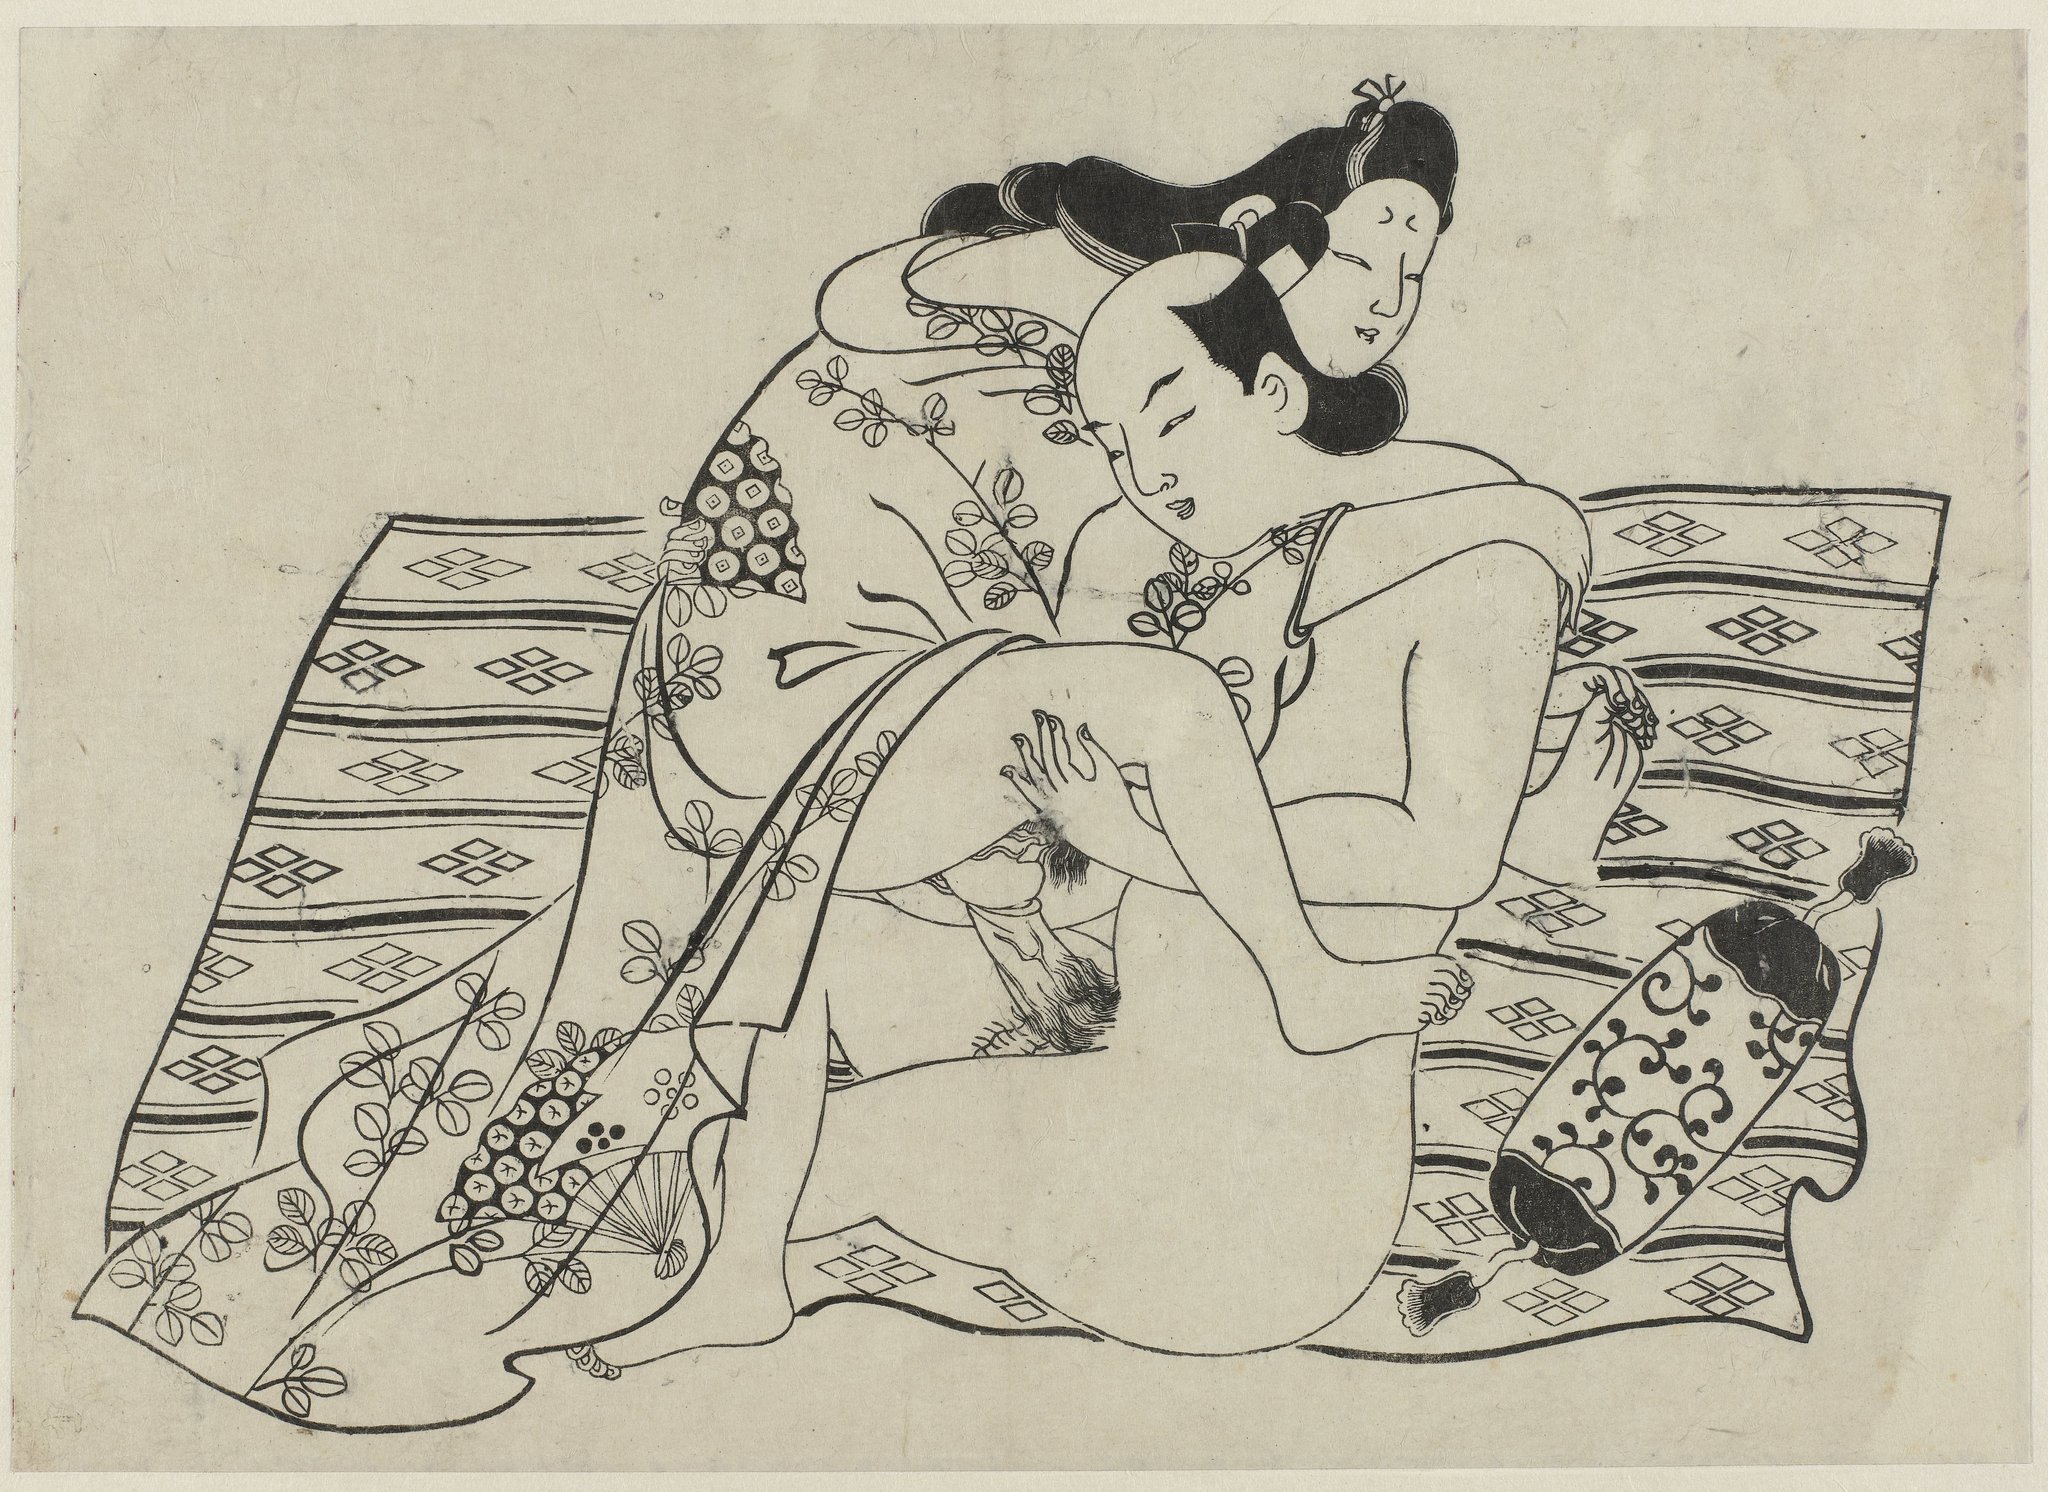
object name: print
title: Erotische voorstelling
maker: sugimura jihei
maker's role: print maker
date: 1680-1698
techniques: woodcut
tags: blanket, man and woman cohabiting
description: Een vrijend paar, zittend op een deken met streep- en ruitpatronen.